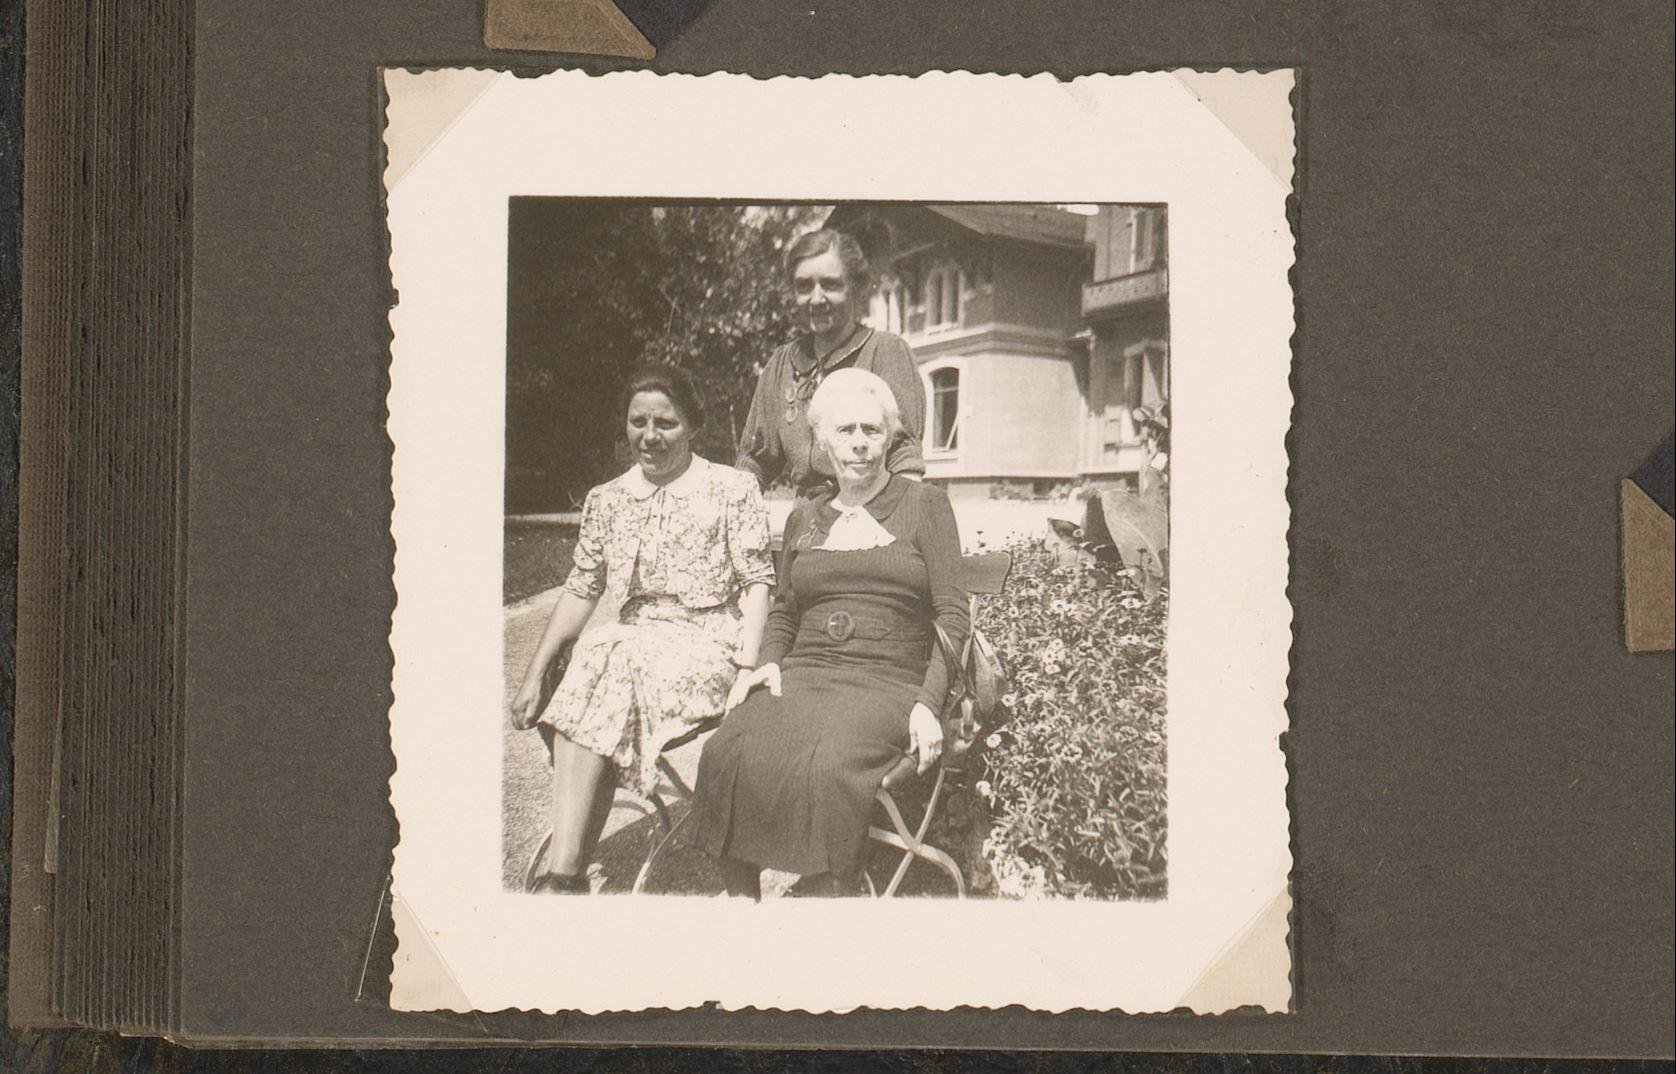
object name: photograph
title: Portret van drie vrouwen in een tuin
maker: Anonymous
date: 1920-1940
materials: photographic support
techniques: gelatin silver print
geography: netherlands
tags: garden, historical persons, adult woman (+ three persons)